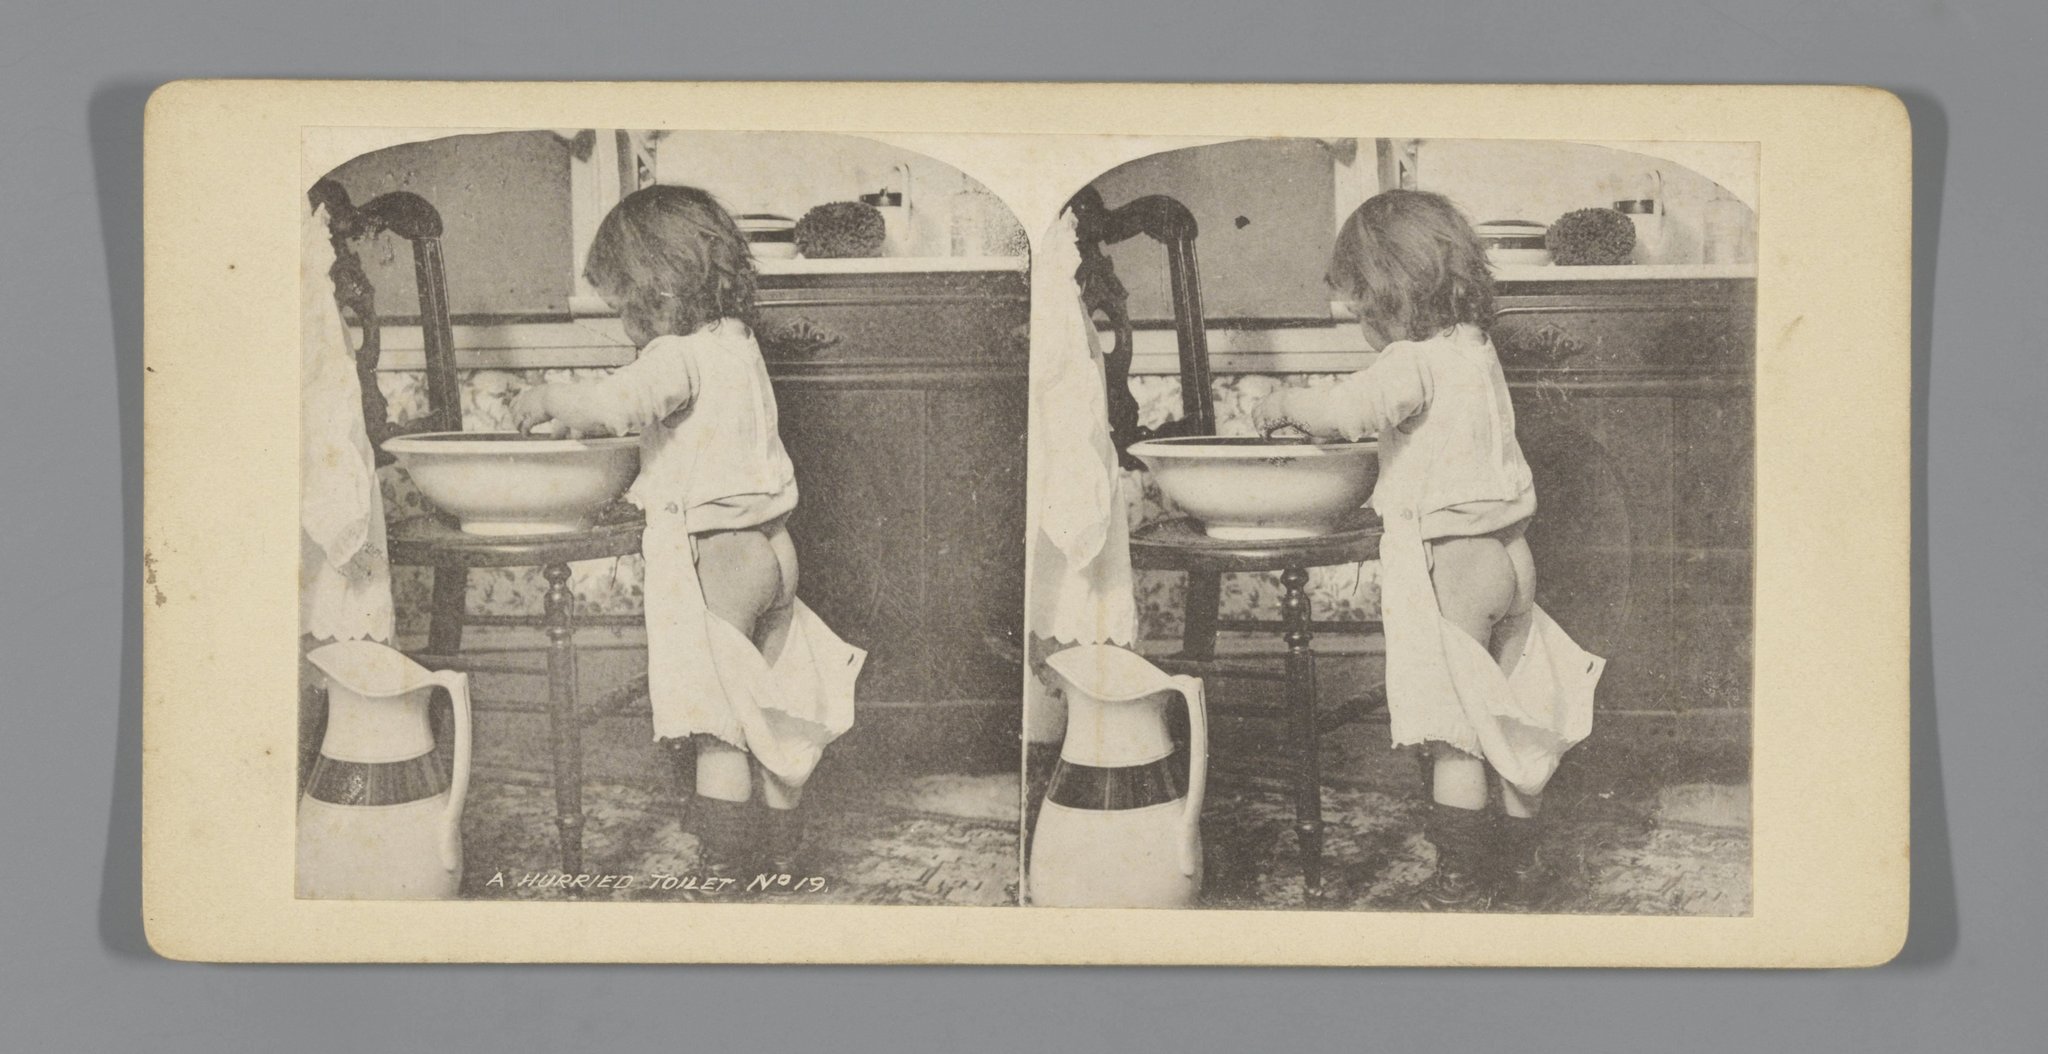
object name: photomechanical print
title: A hurried toilet No. 19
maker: Anonymous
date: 1890-1920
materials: cardboard, paper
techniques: photograph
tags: jug and basin; wash-basin, child (at home) - aa - girl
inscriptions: annotation: ‘Va’